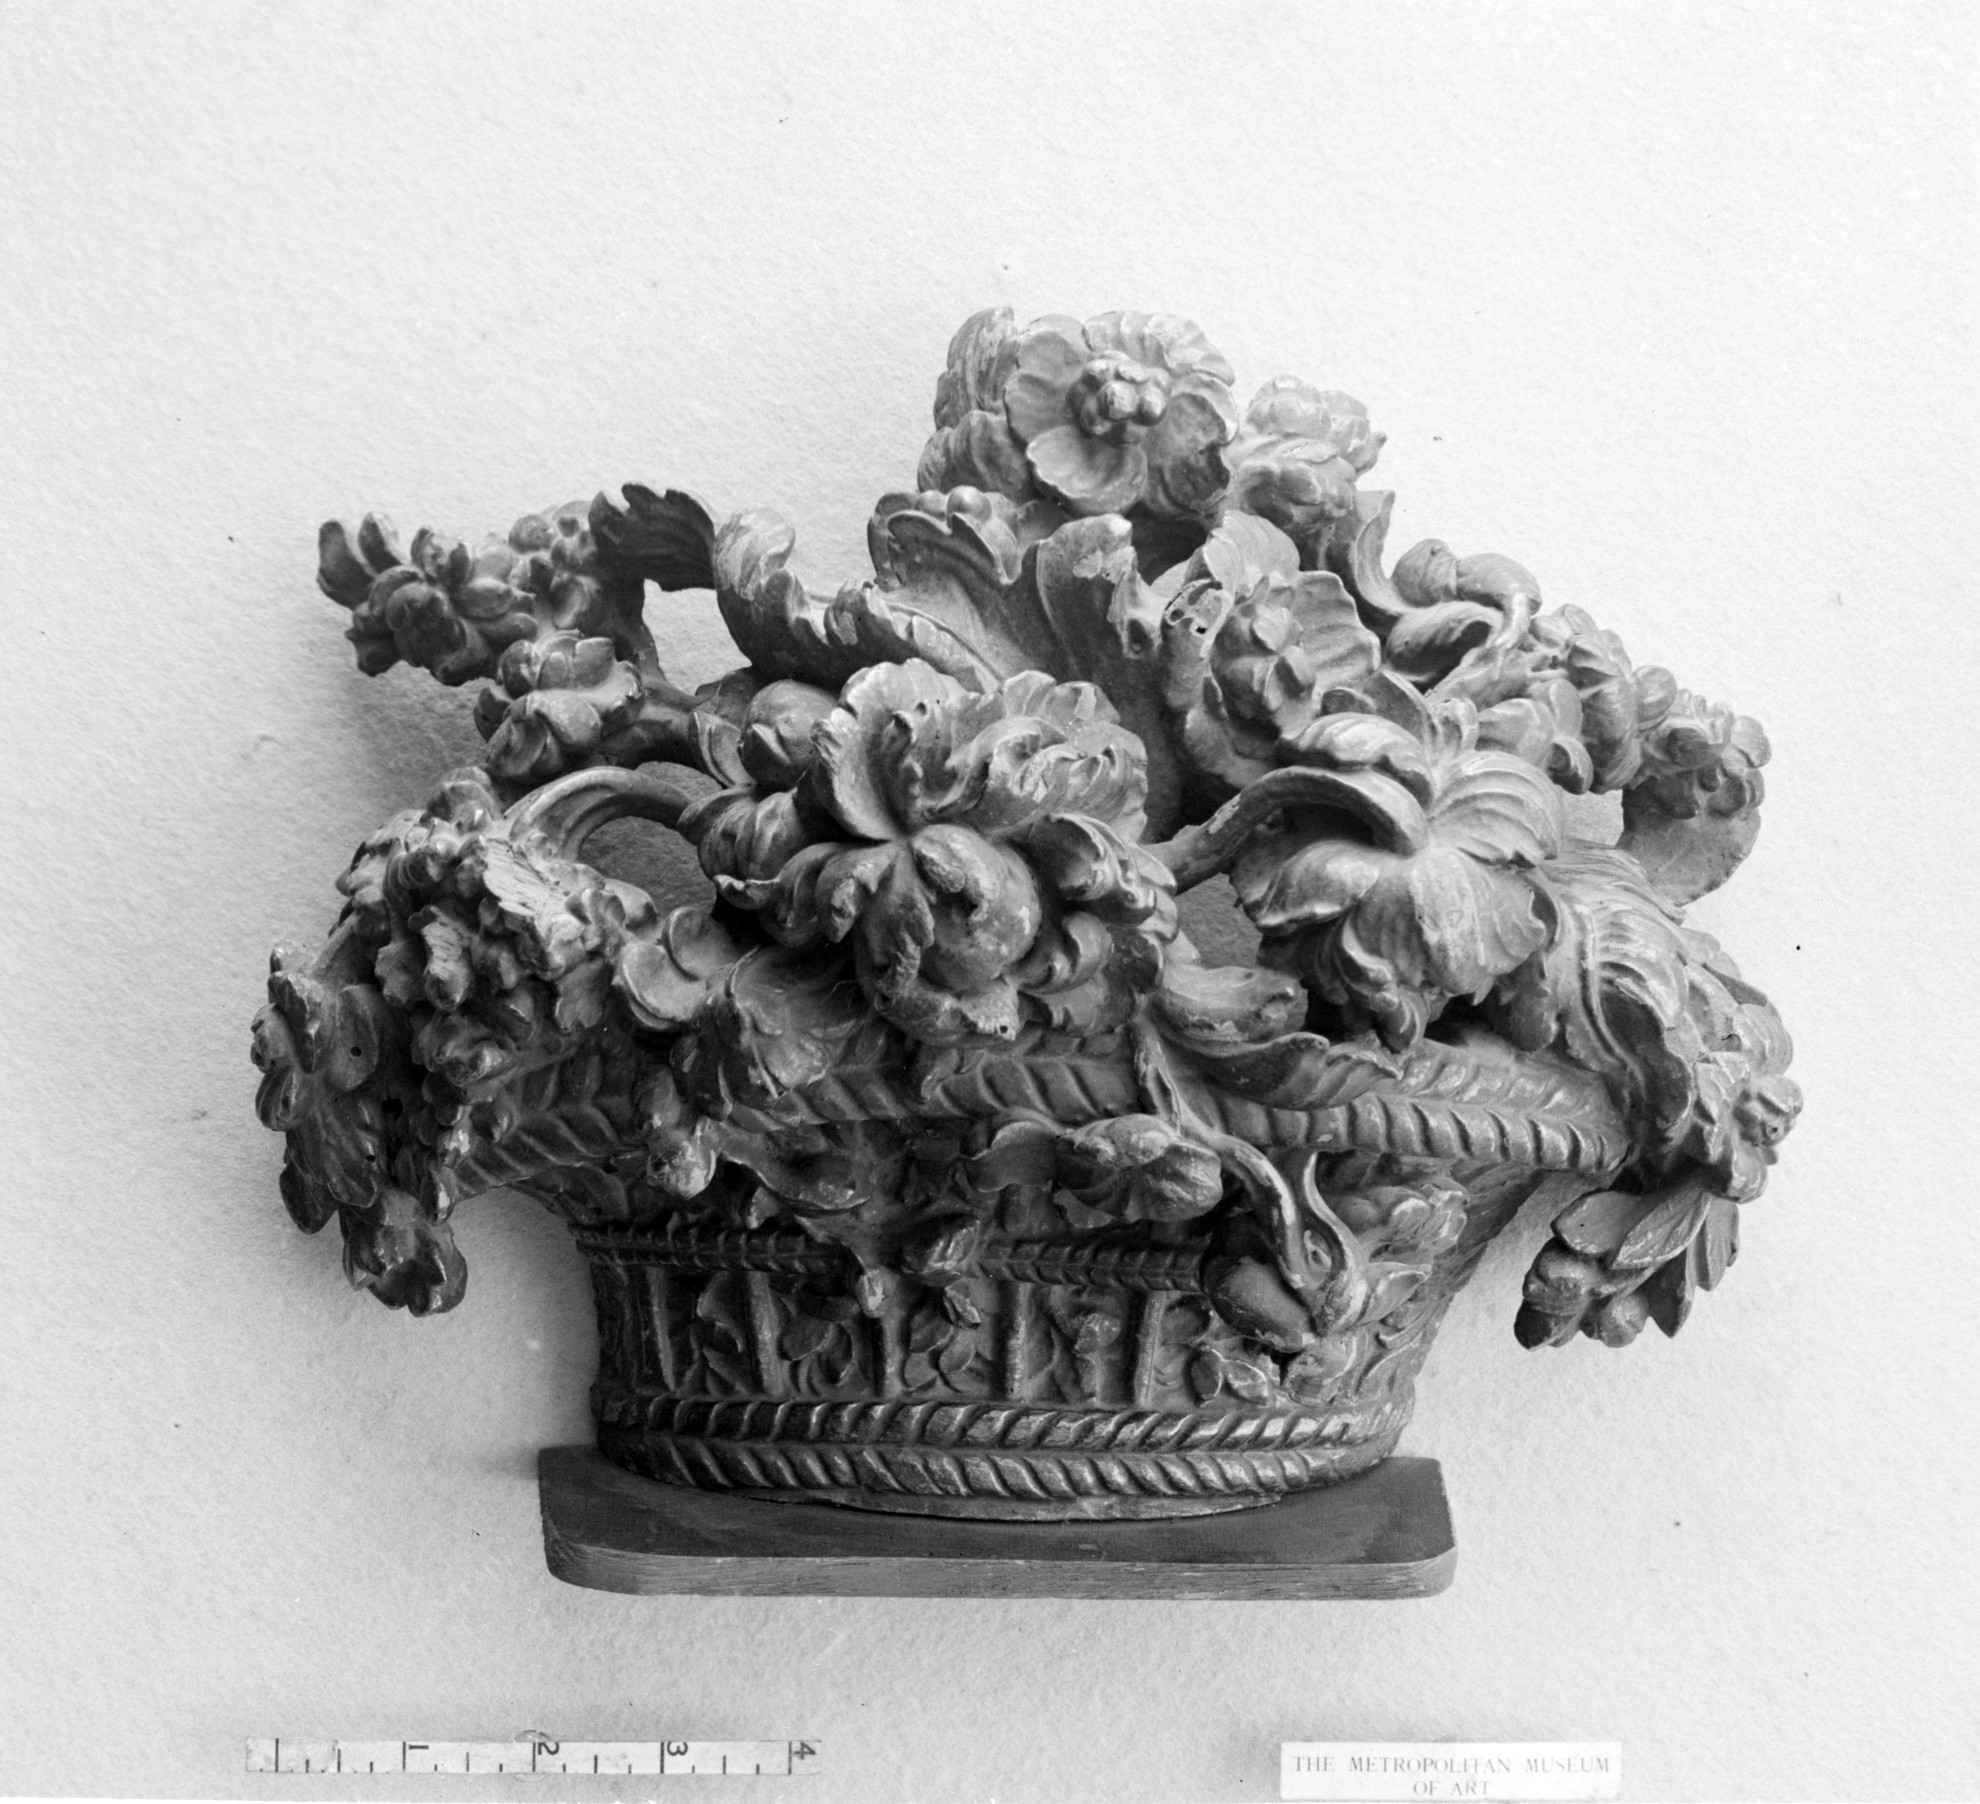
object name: console ornament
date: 1701-1800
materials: gilt, wood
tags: flowers